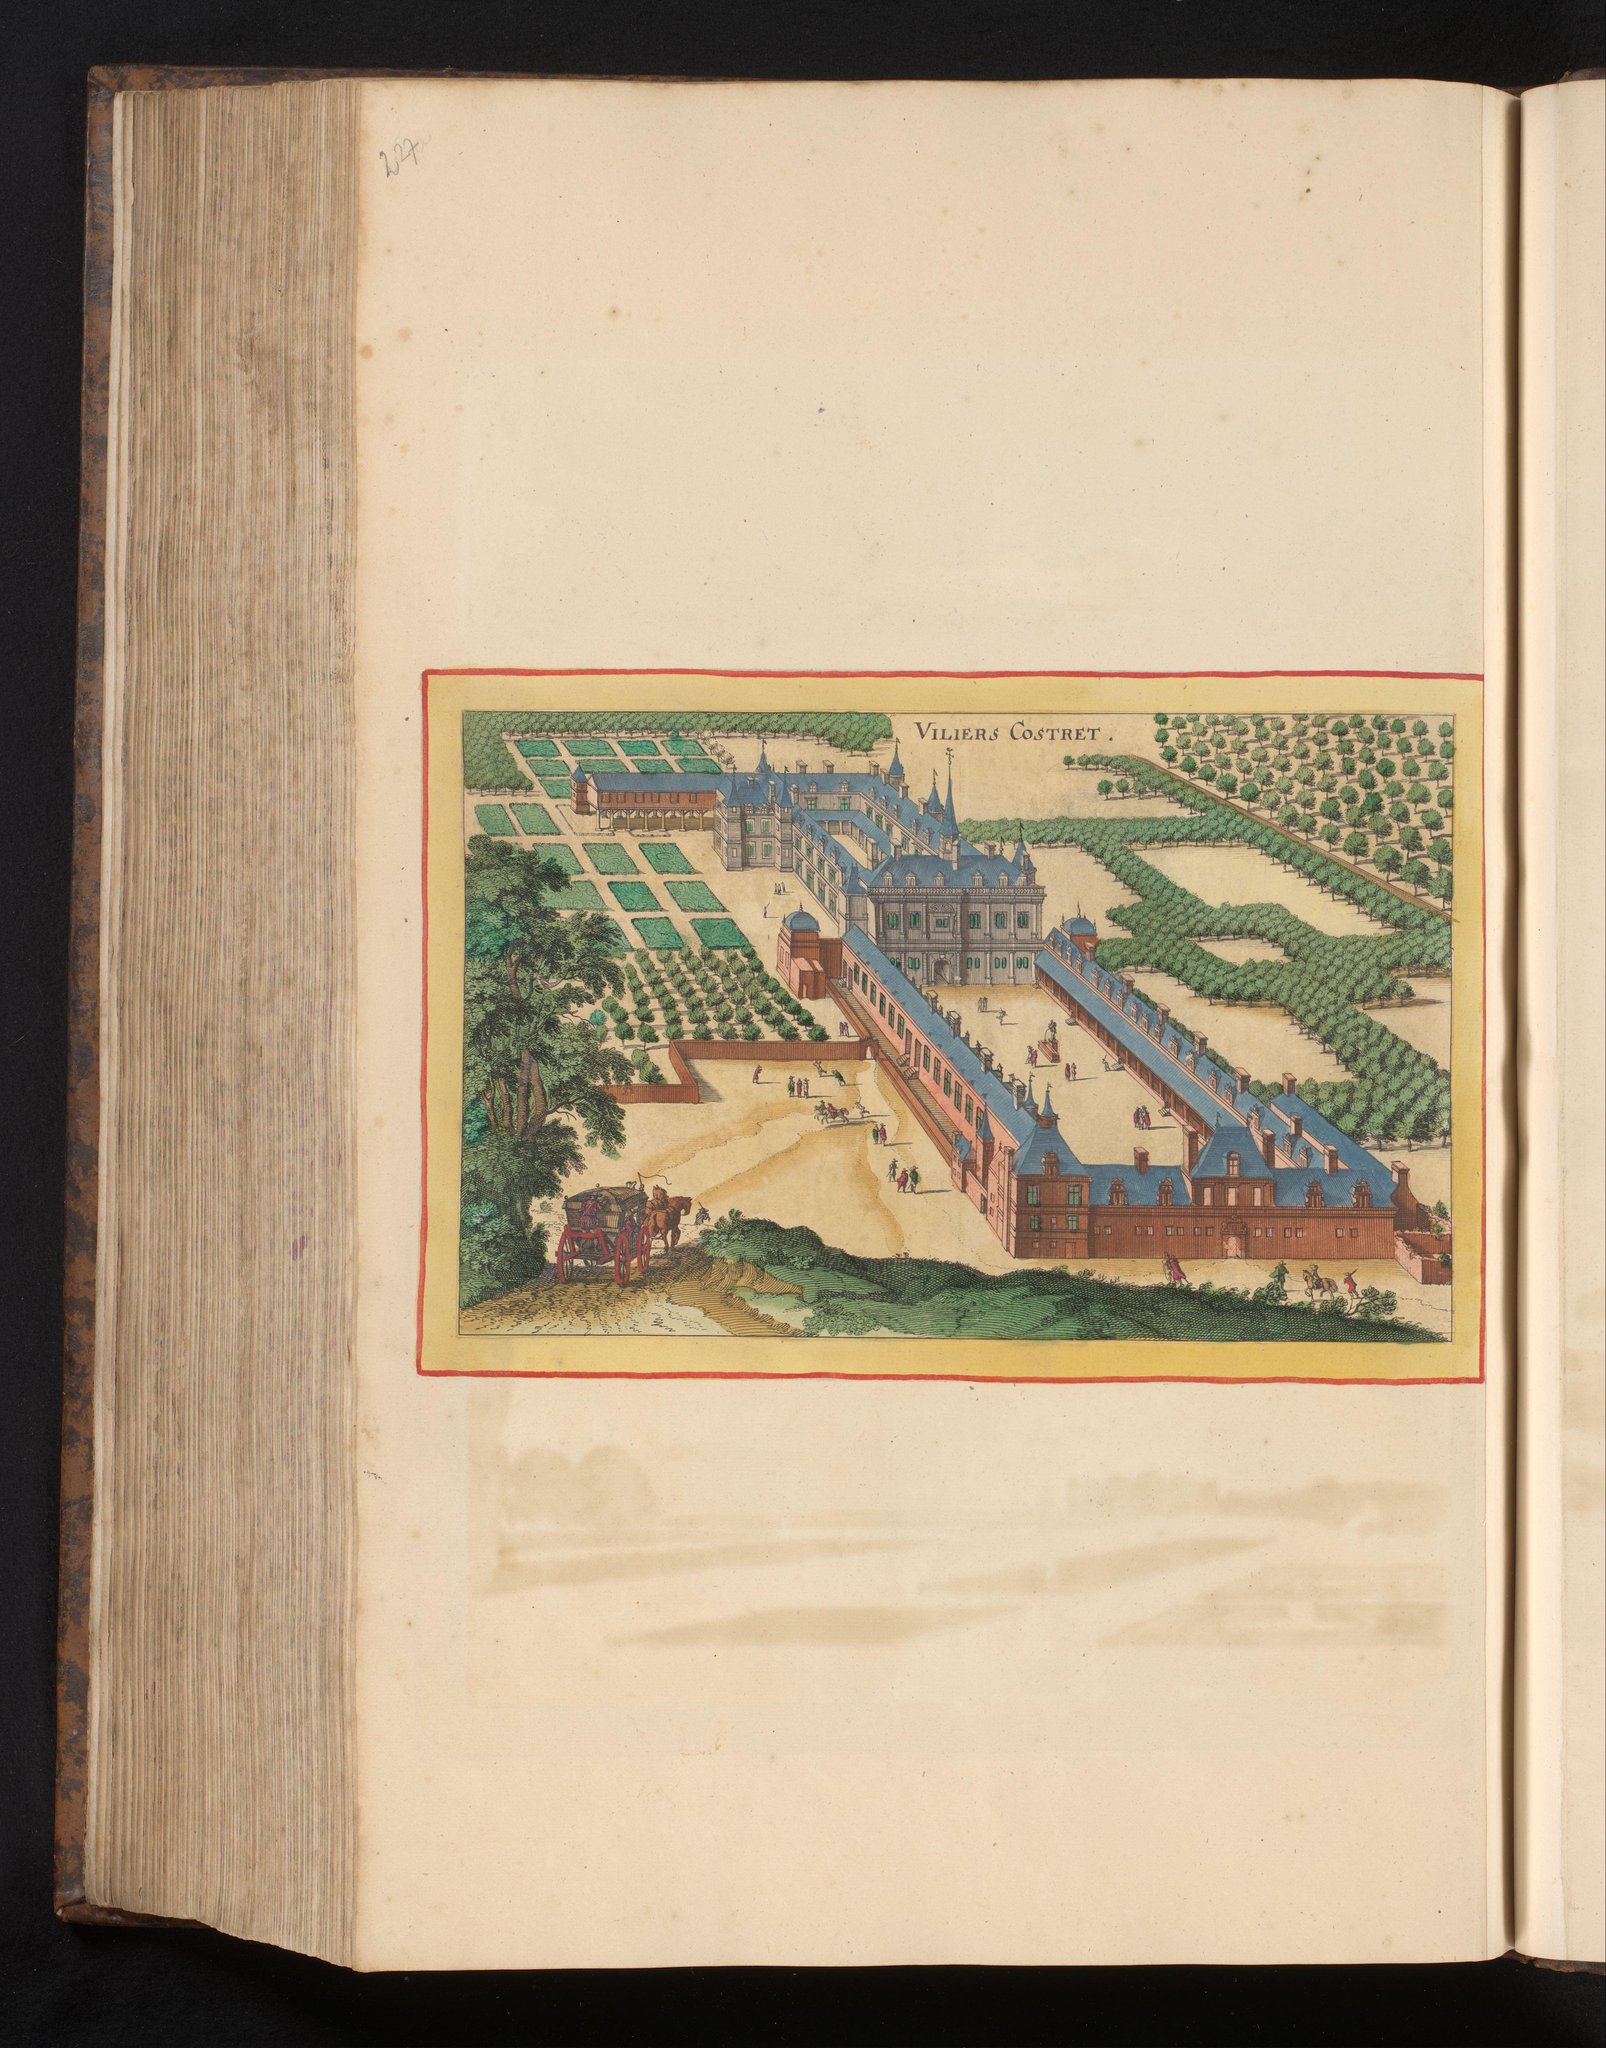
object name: album leaf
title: Gezicht op Château de Villers-Cotterêts in vogelvluchtperspectief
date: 1655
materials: paper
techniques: engraving, etching, hand coloring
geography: the hague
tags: castle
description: Prent origineel vervaardigd als boekillustratie voor: Zeiller, Martin. Topographia Galliae, oder Beschreibung und Contrafaitung der vornehmbsten und bekantisten Oerter in dem mächtigen und grossen Königreich Frankreich, 13 delen. Frankfurt am Main: Caspar Merian, 1655-1661. De prent werd voor het eerst gepubliceerd in deel 1: Topographia Galliae, 1655.